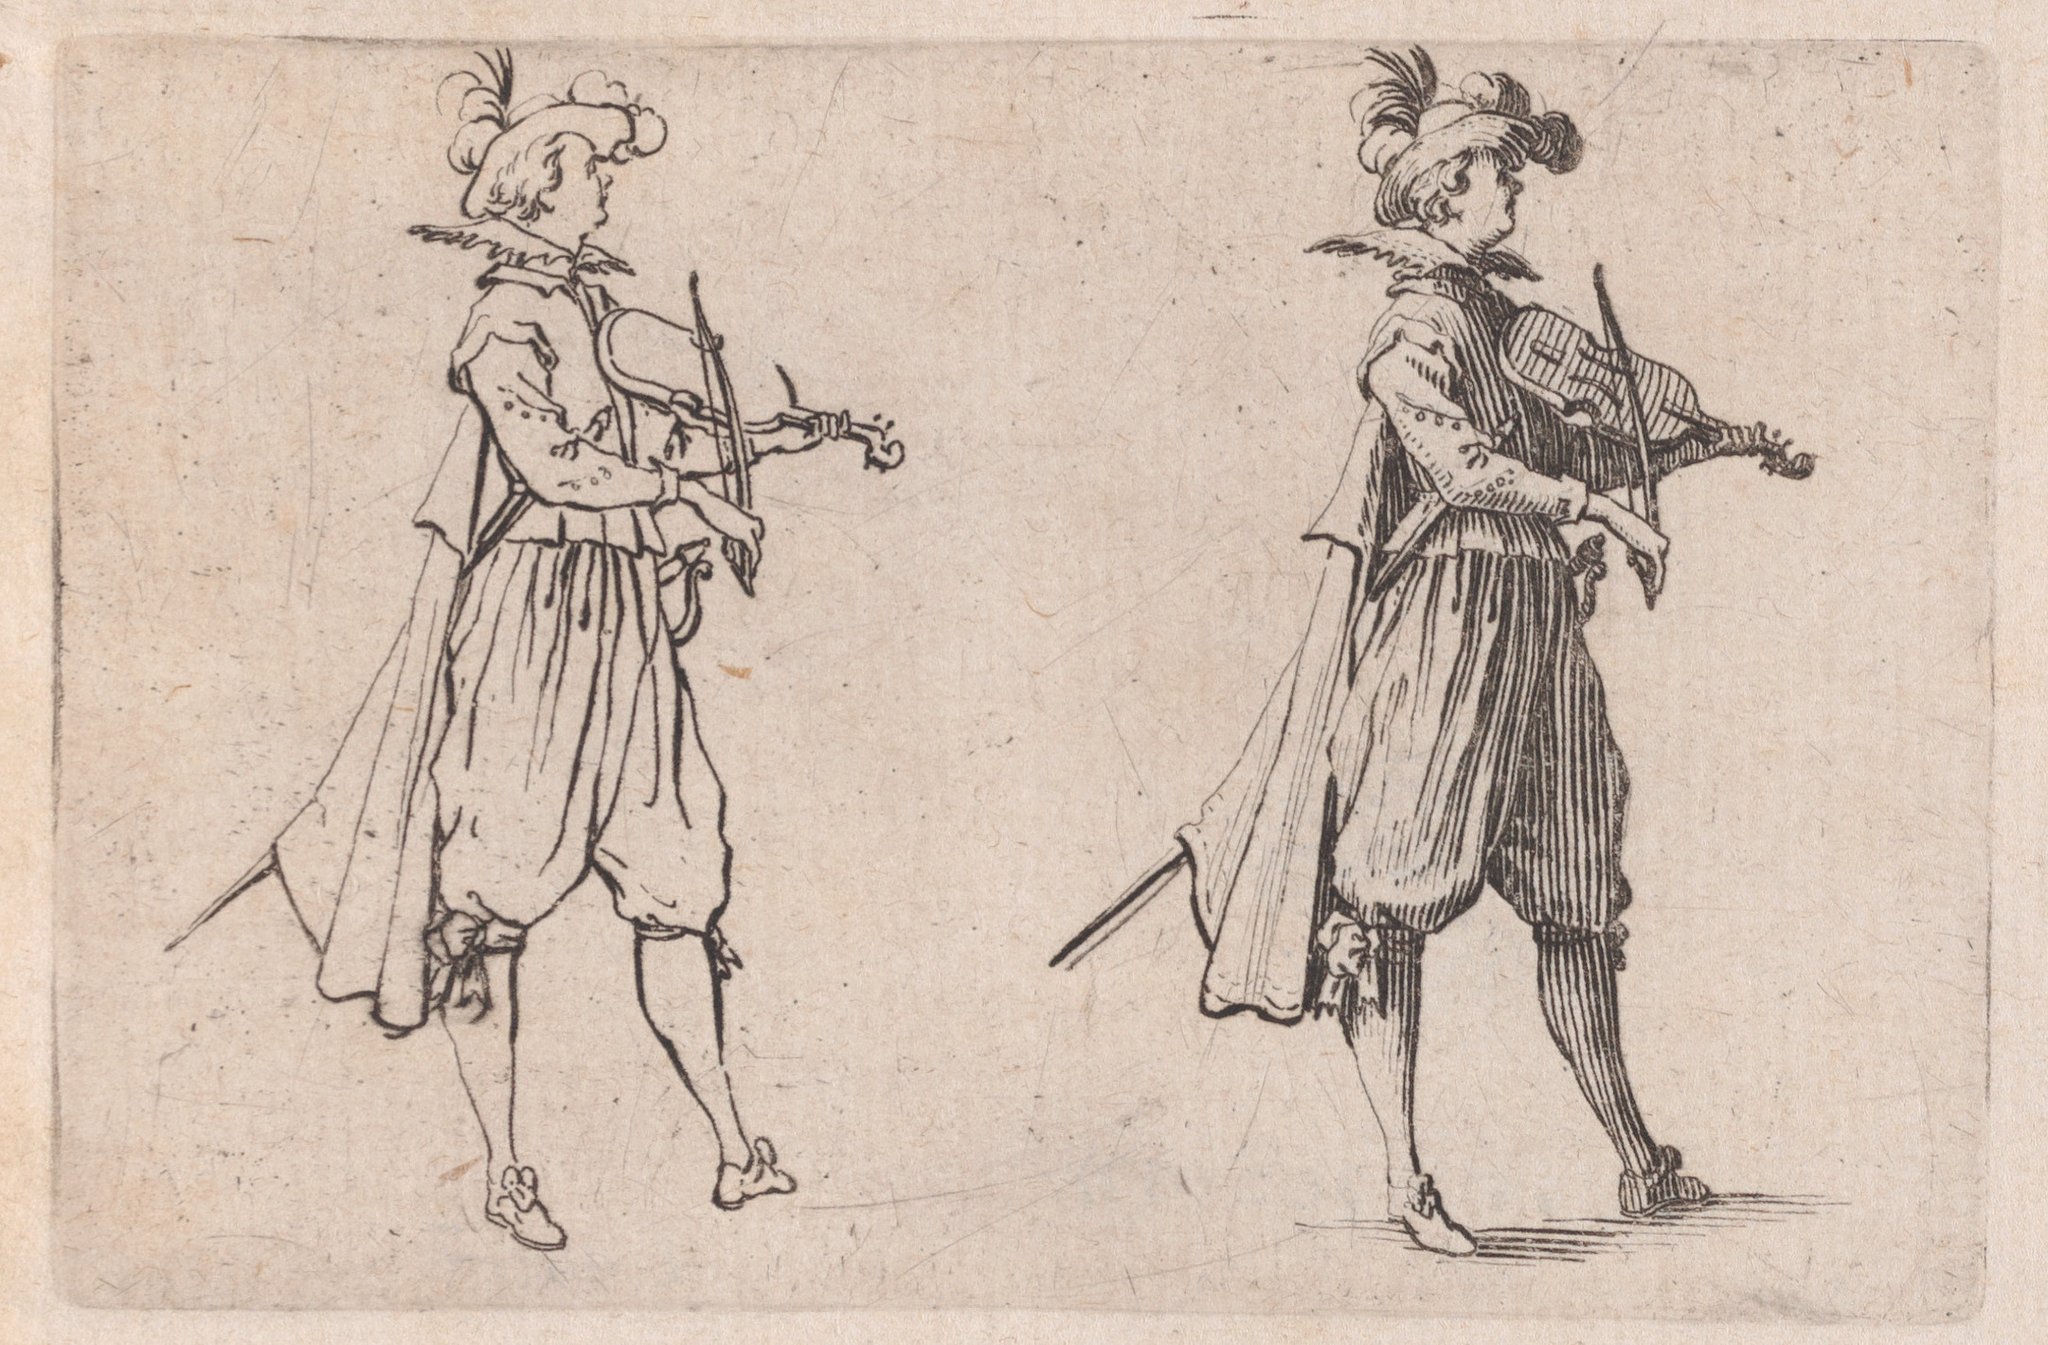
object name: print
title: Le Jouer de Violon (The Violin Player), from "Les Caprices" Series B, The Nancy Set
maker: jacques callot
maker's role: artist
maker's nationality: french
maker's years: 1592-1635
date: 1617-1620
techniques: etching